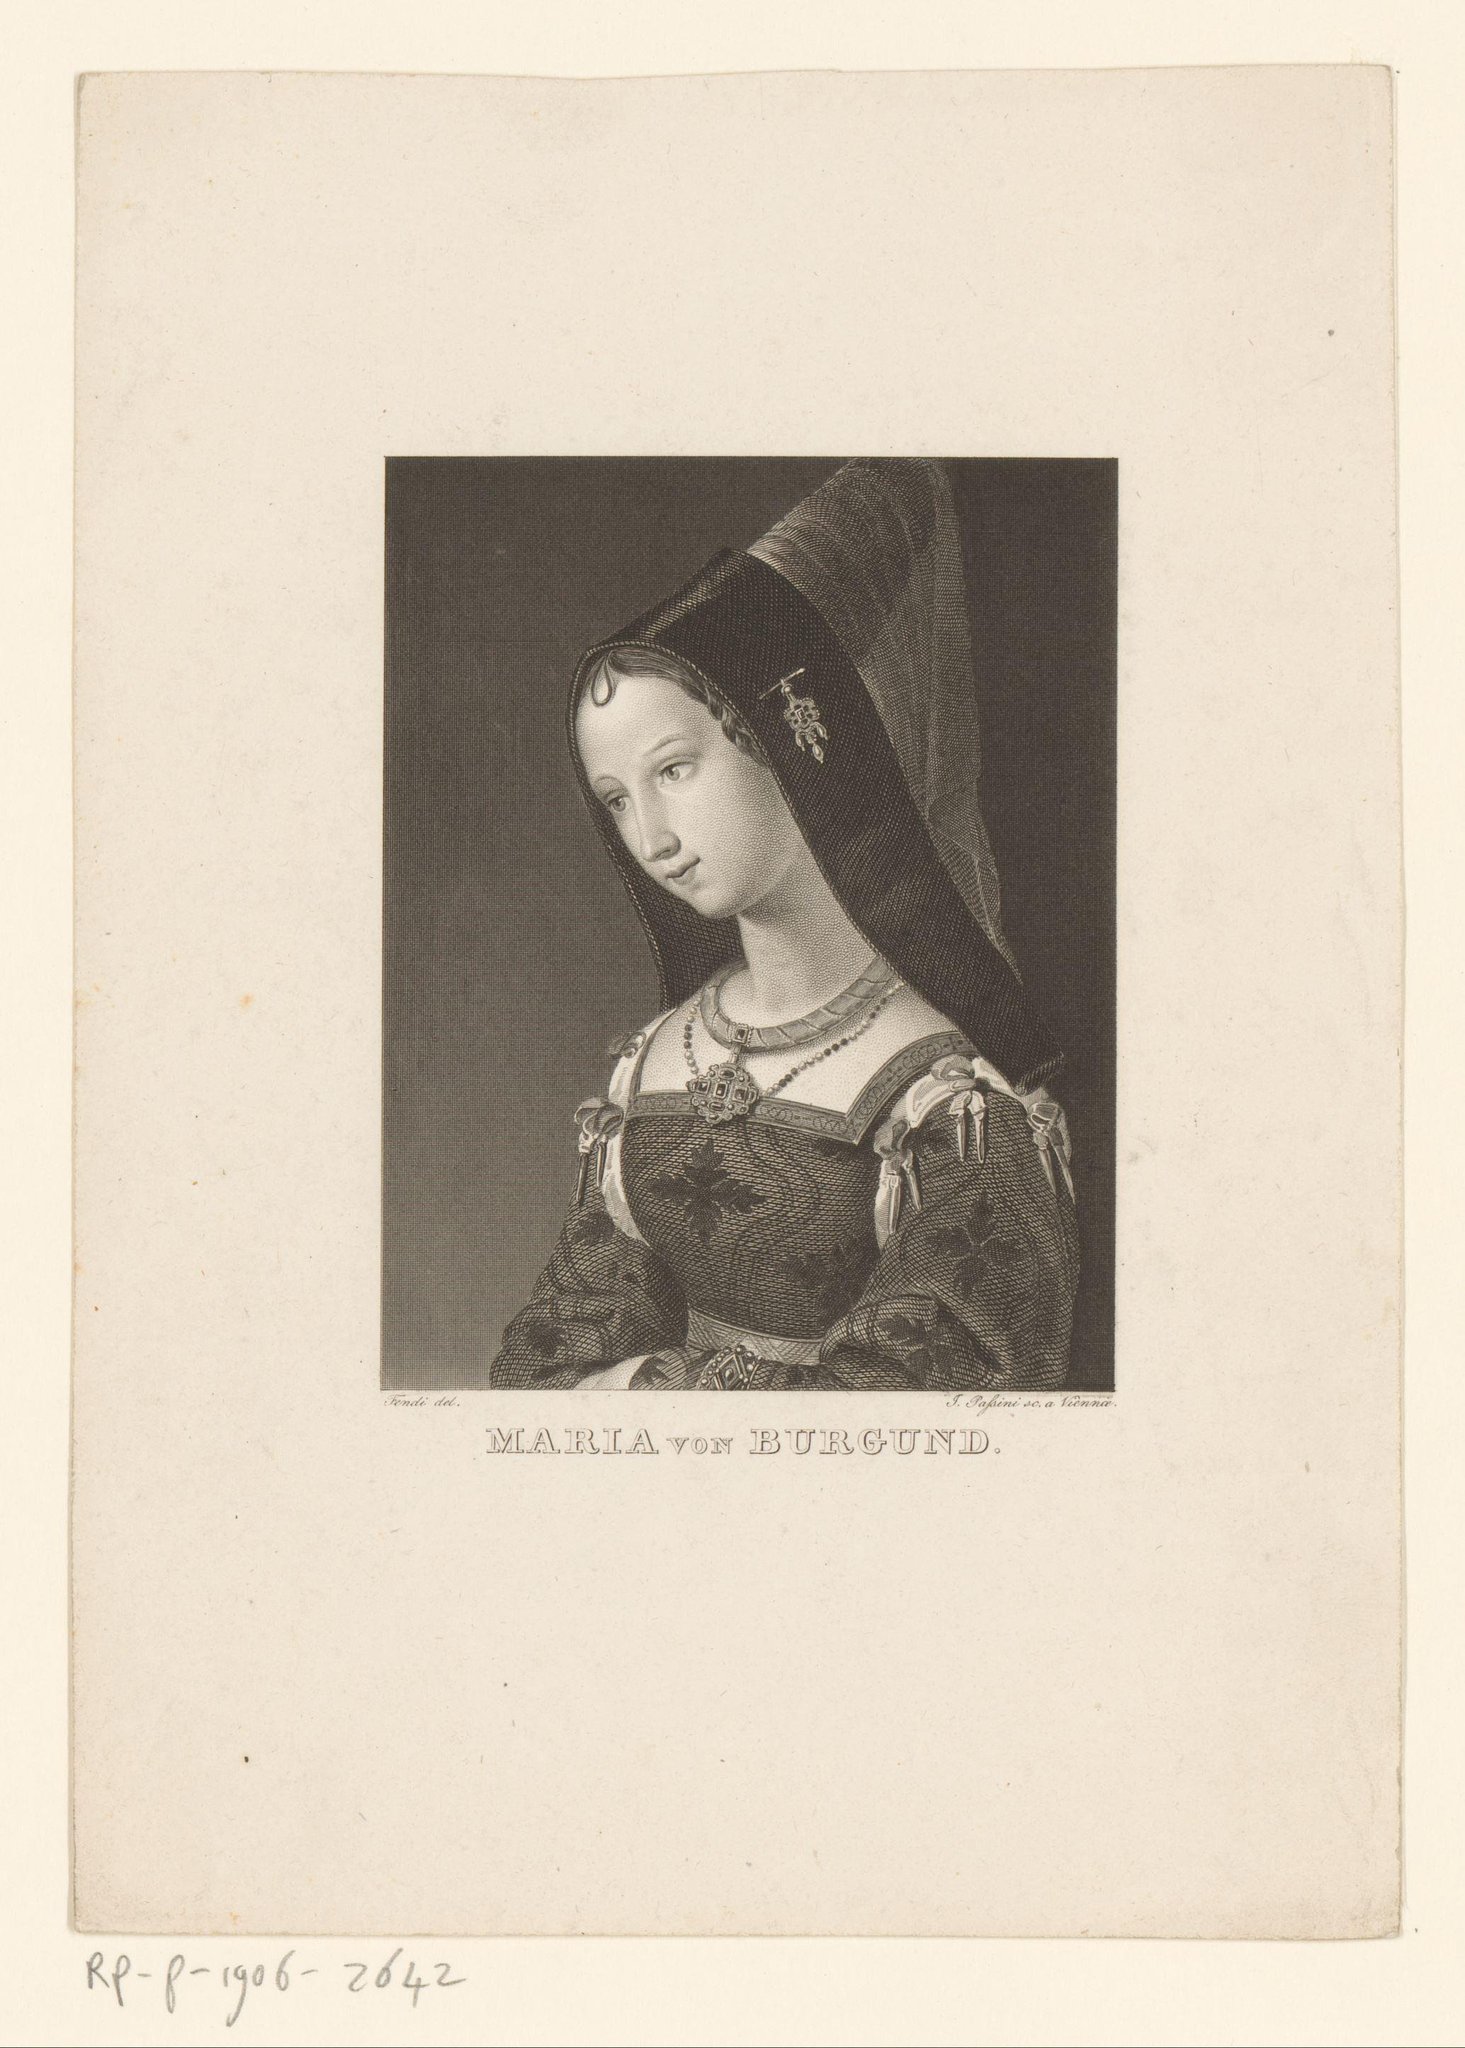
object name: print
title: Portret van Maria van Bourgondië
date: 1808-1874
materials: paper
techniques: engraving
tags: brussels, bruges, maria (hertogin van bourgondië), historical persons - bb - woman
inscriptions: collector's mark: Lugt 2228